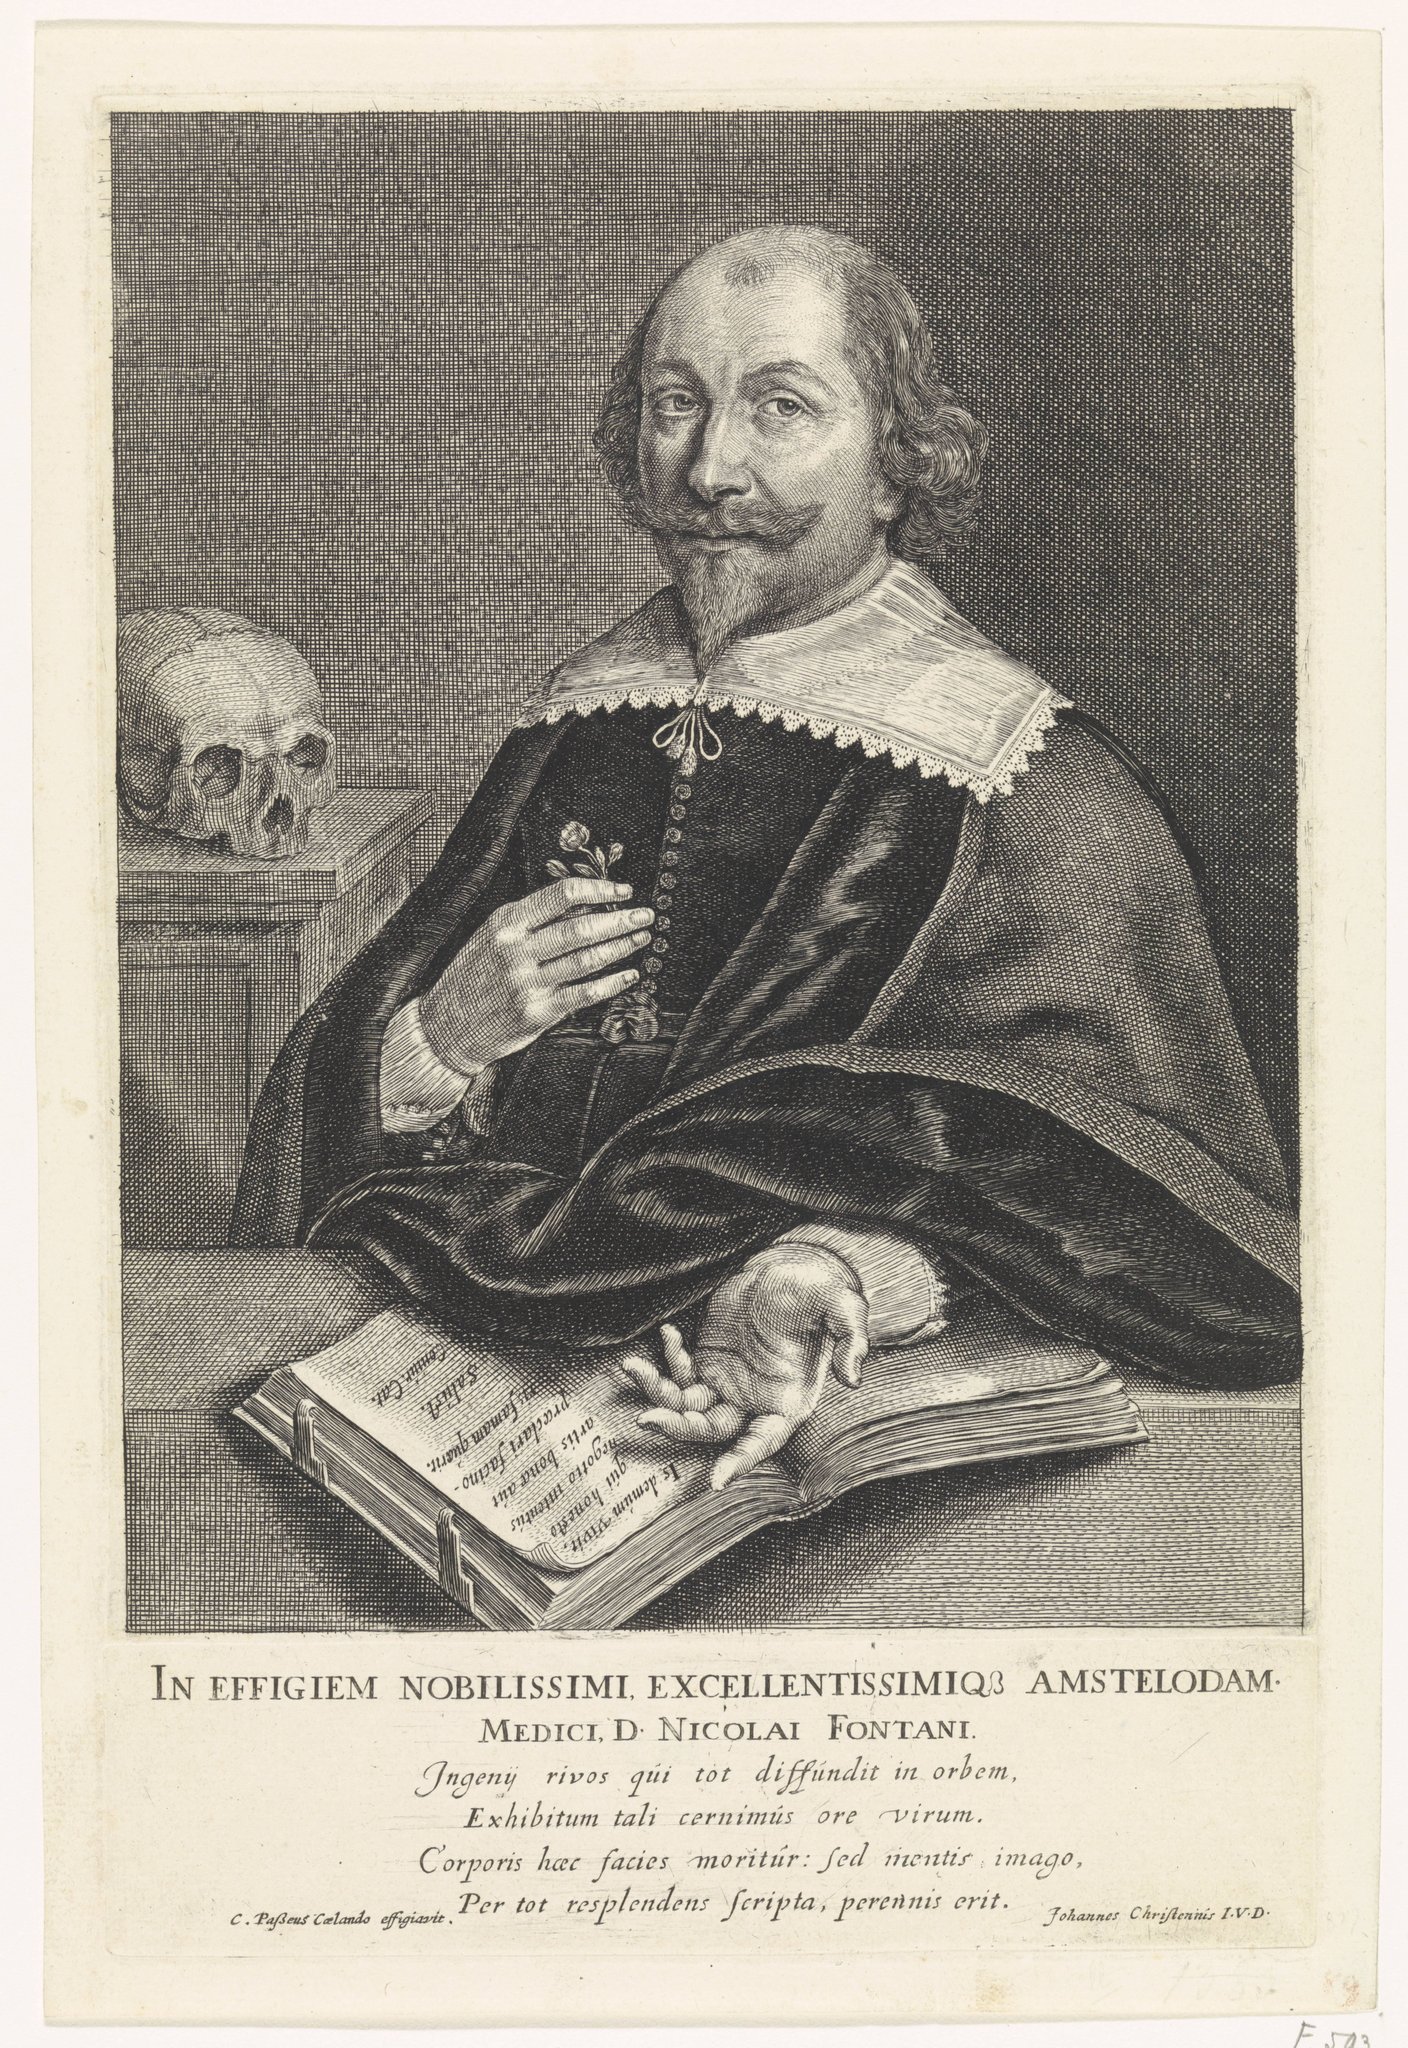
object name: print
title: Portret van Nicolaas Fontanus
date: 1604-1670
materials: paper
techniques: engraving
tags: historical persons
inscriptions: collector's mark: Lugt 2228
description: Portret van de dichter Nicolaas Fontanus. In de marge de naam en functie van de geportretteerde in het Latijn. Daaronder een vierregelig lofdicht in het Latijn.